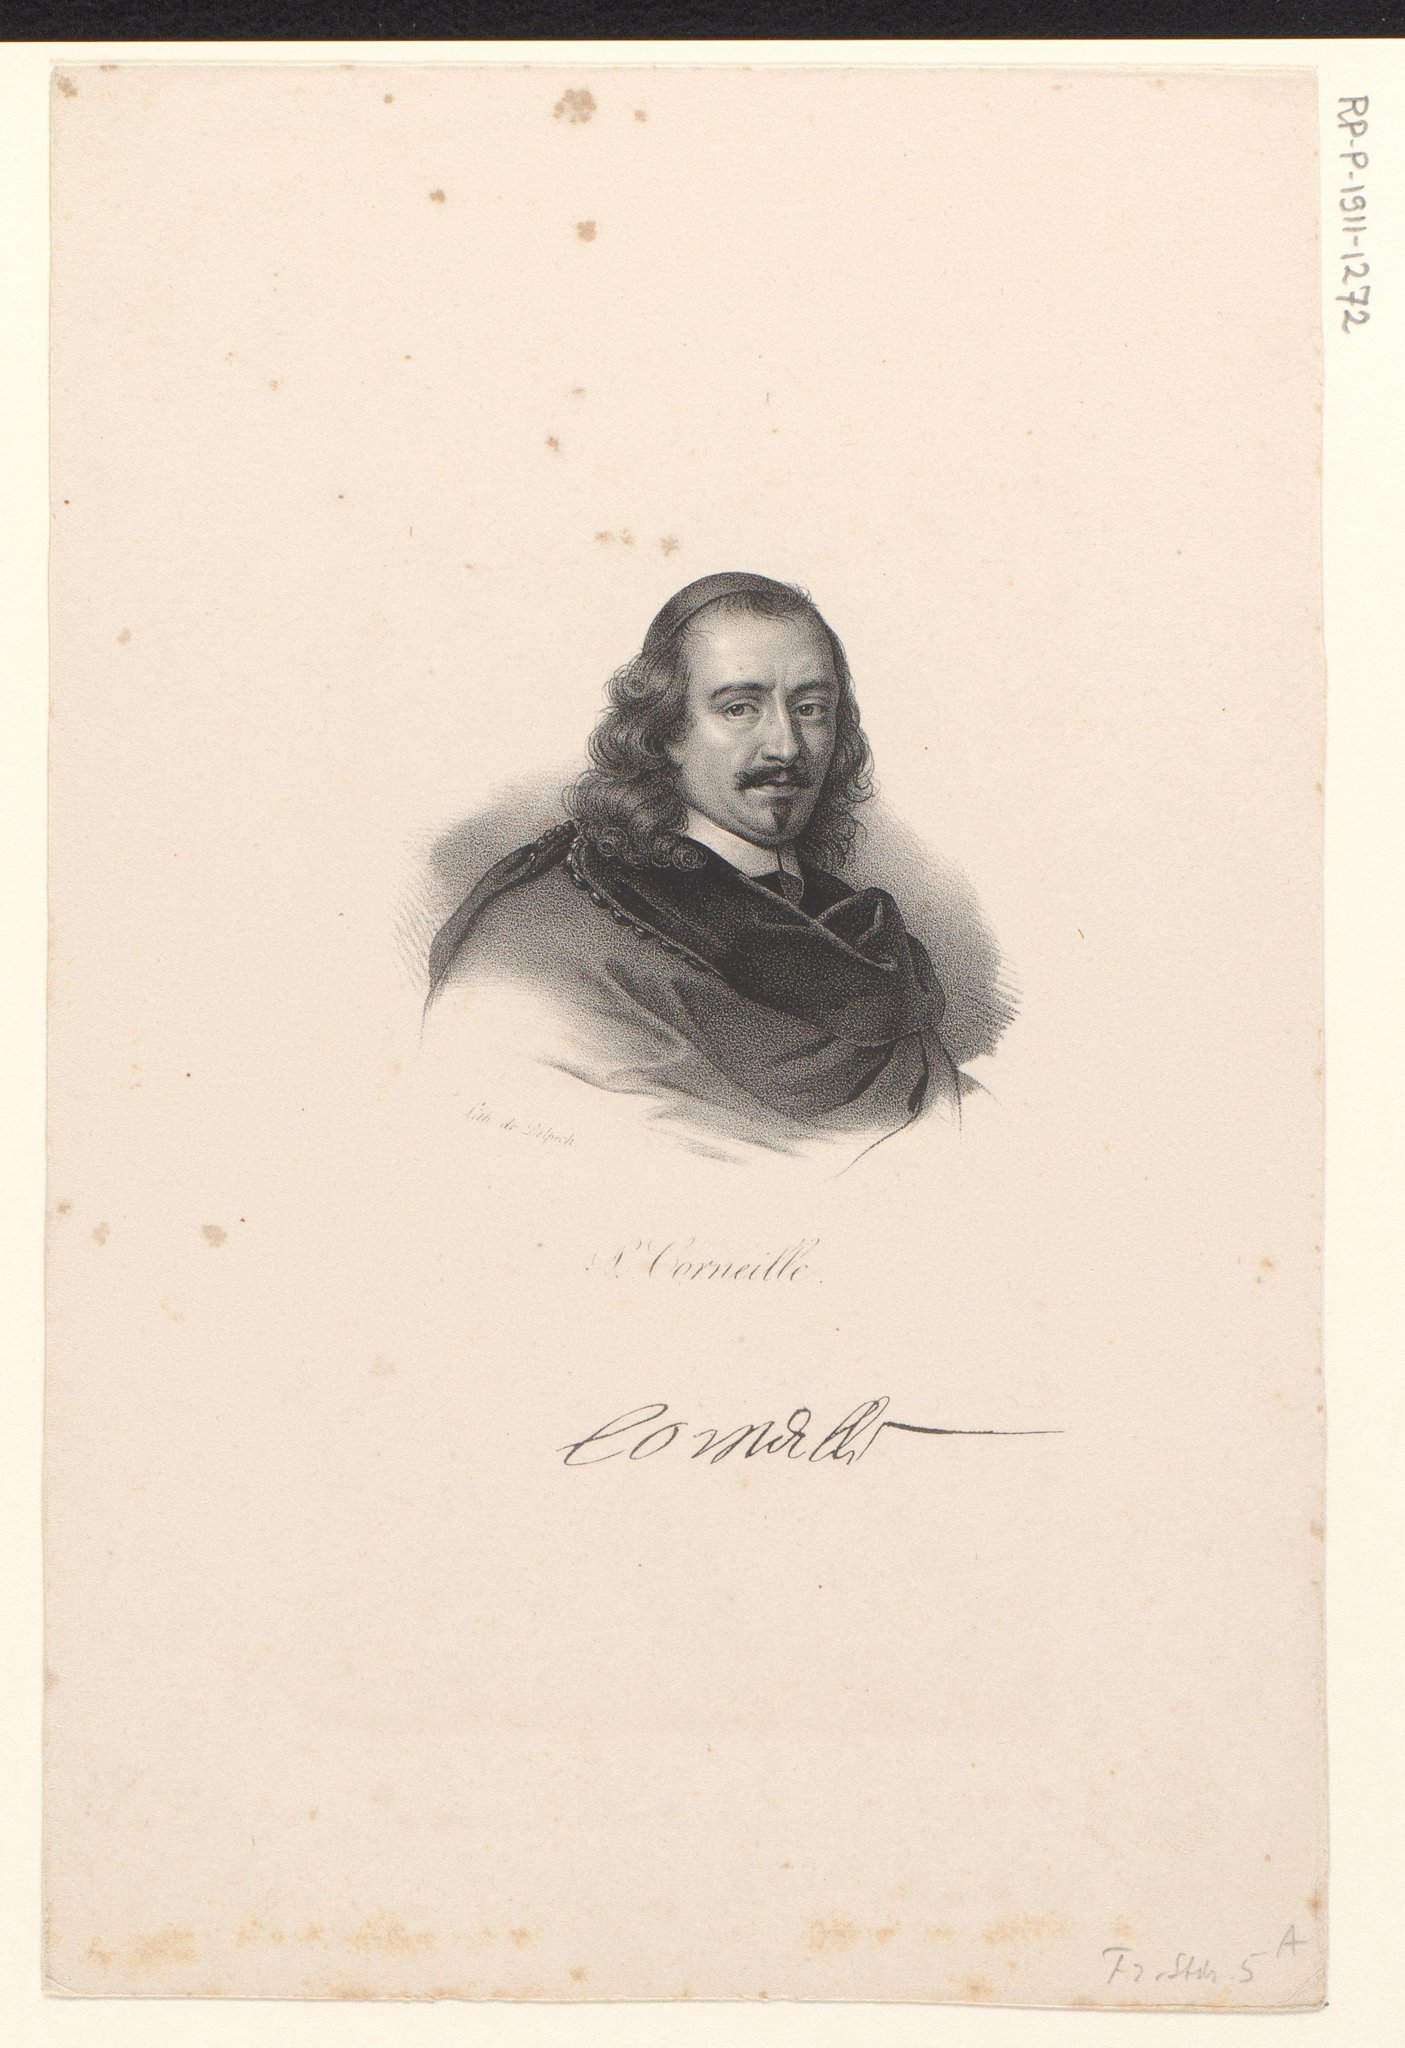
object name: print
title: P. Corneille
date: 1818-1842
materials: paper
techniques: lithograph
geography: paris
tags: pierre corneille, historical persons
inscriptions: collector's mark: Lugt 2228a